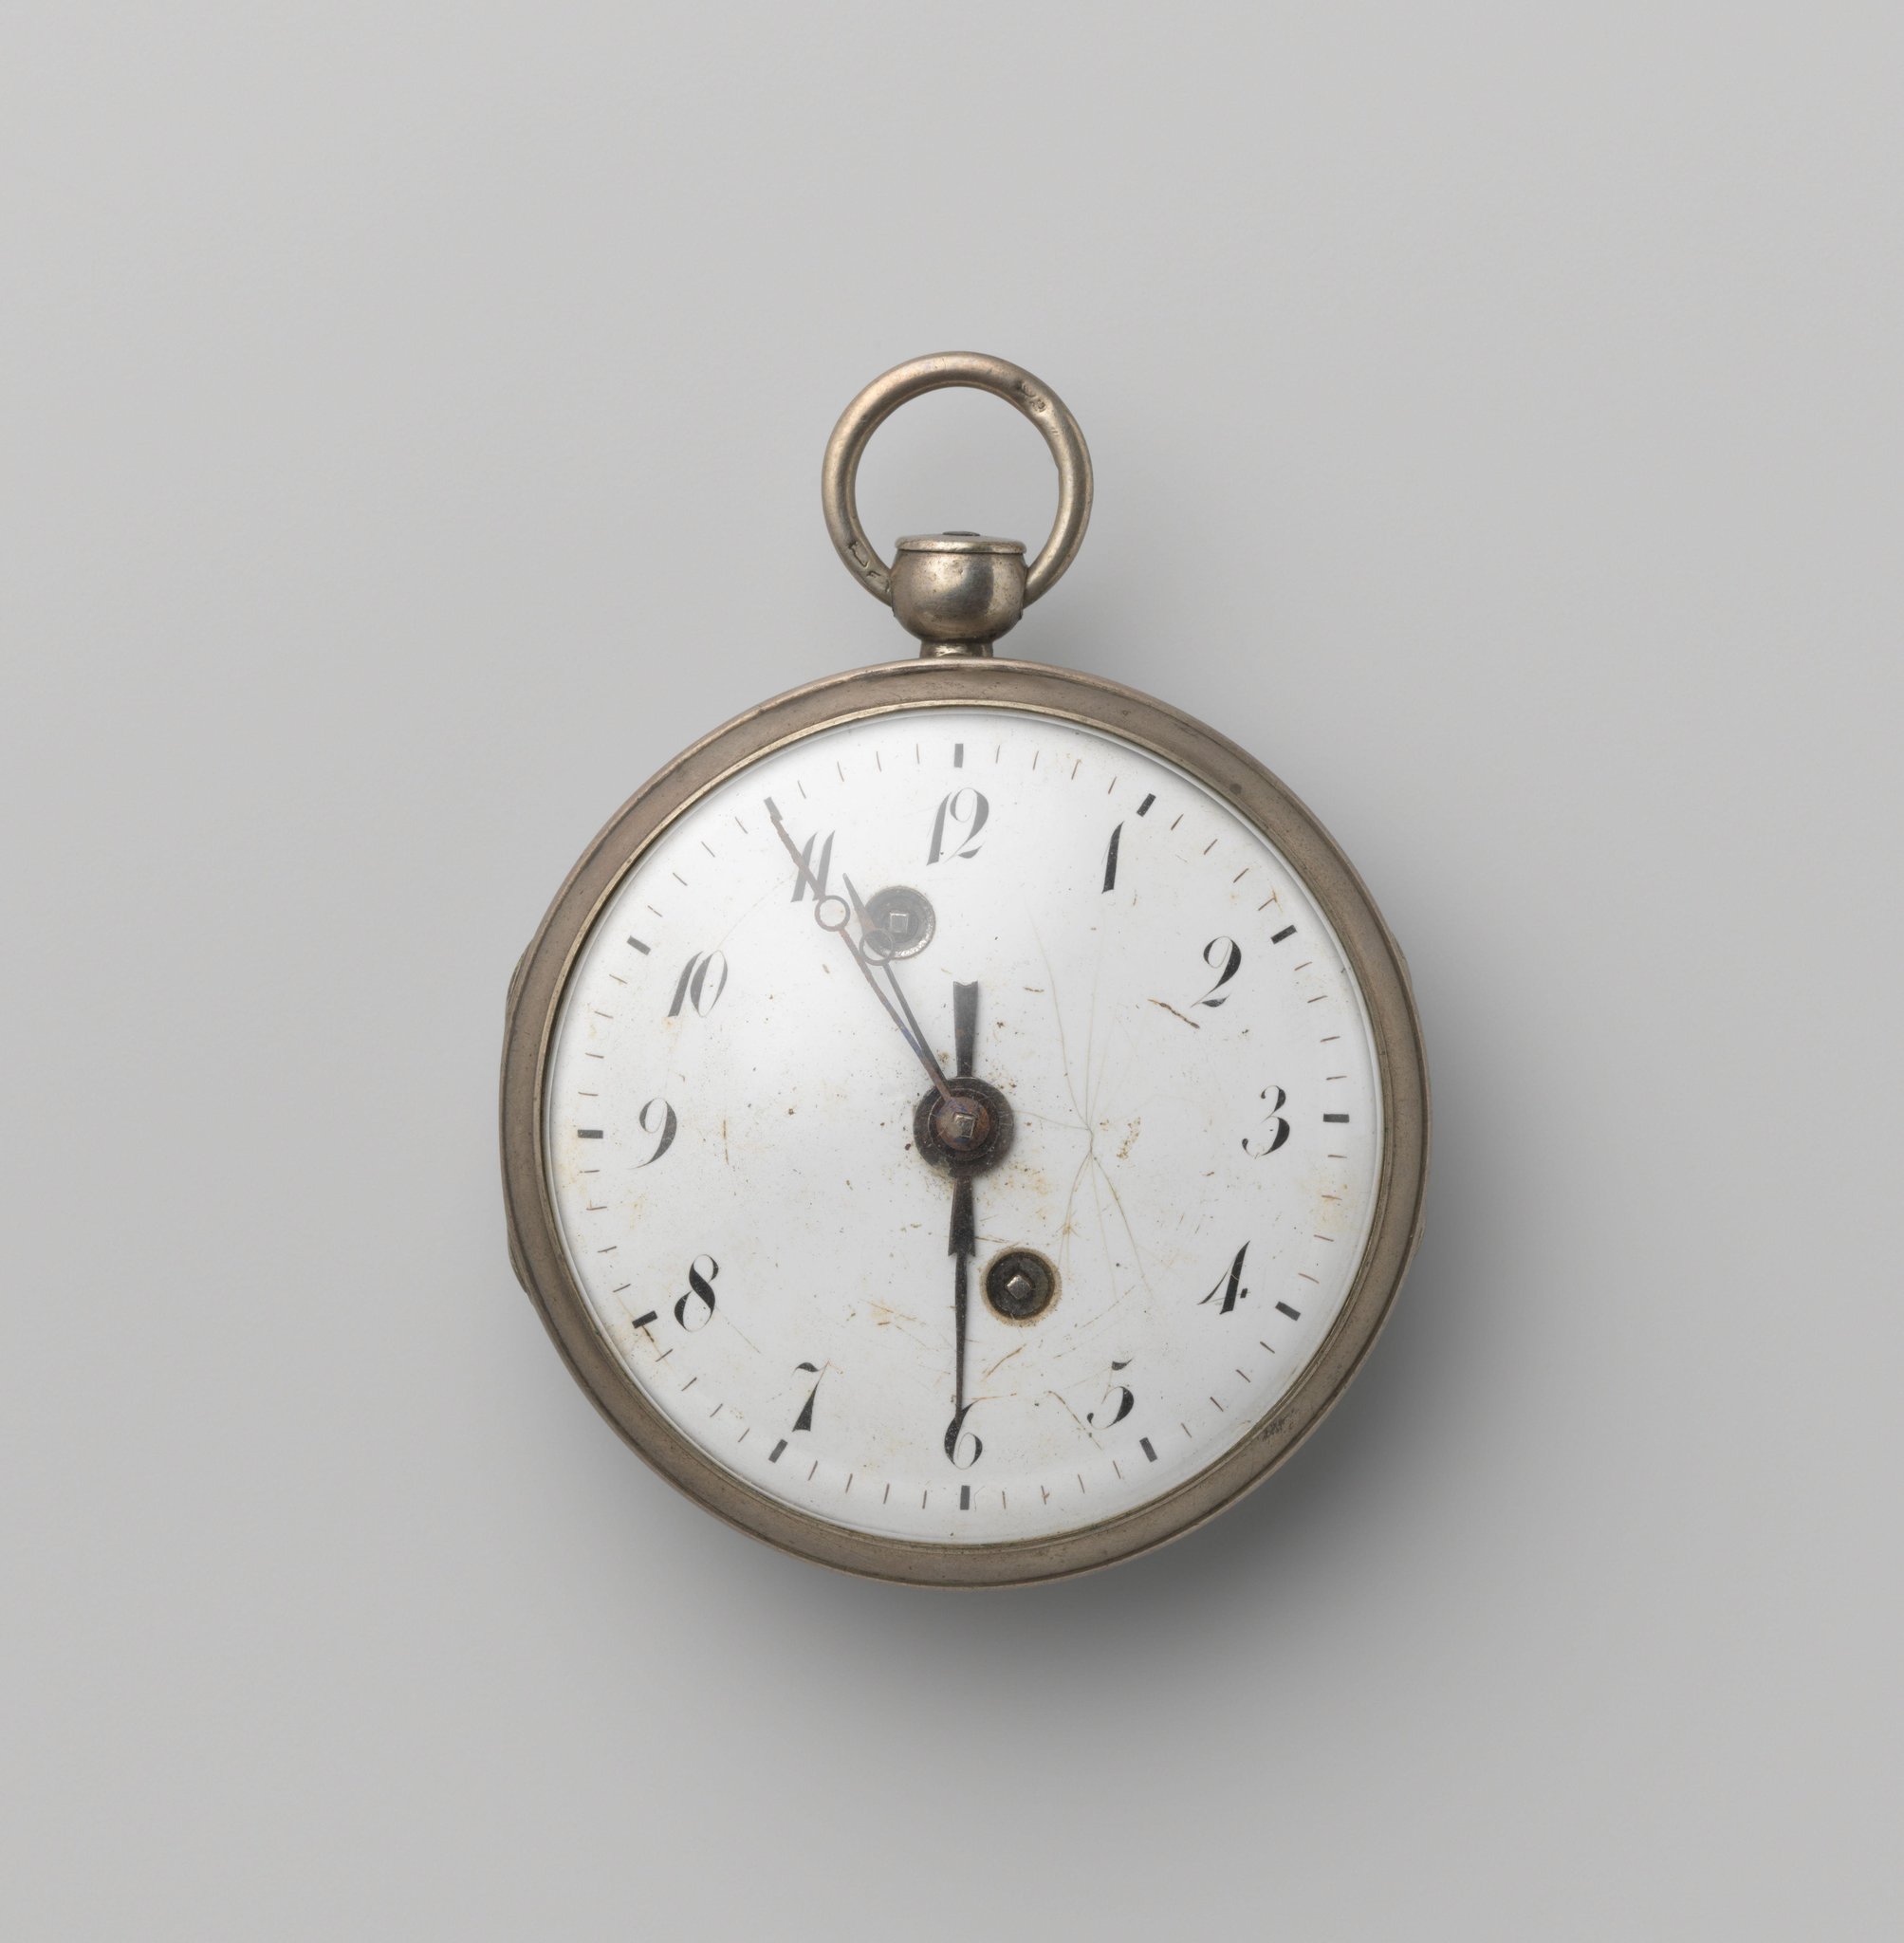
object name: wrist watch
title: Horloge van zilver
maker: Anonymous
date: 1850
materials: silver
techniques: engine turning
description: Horloge van zilver, met spillegang. De achterbodem is geguillocheerd.